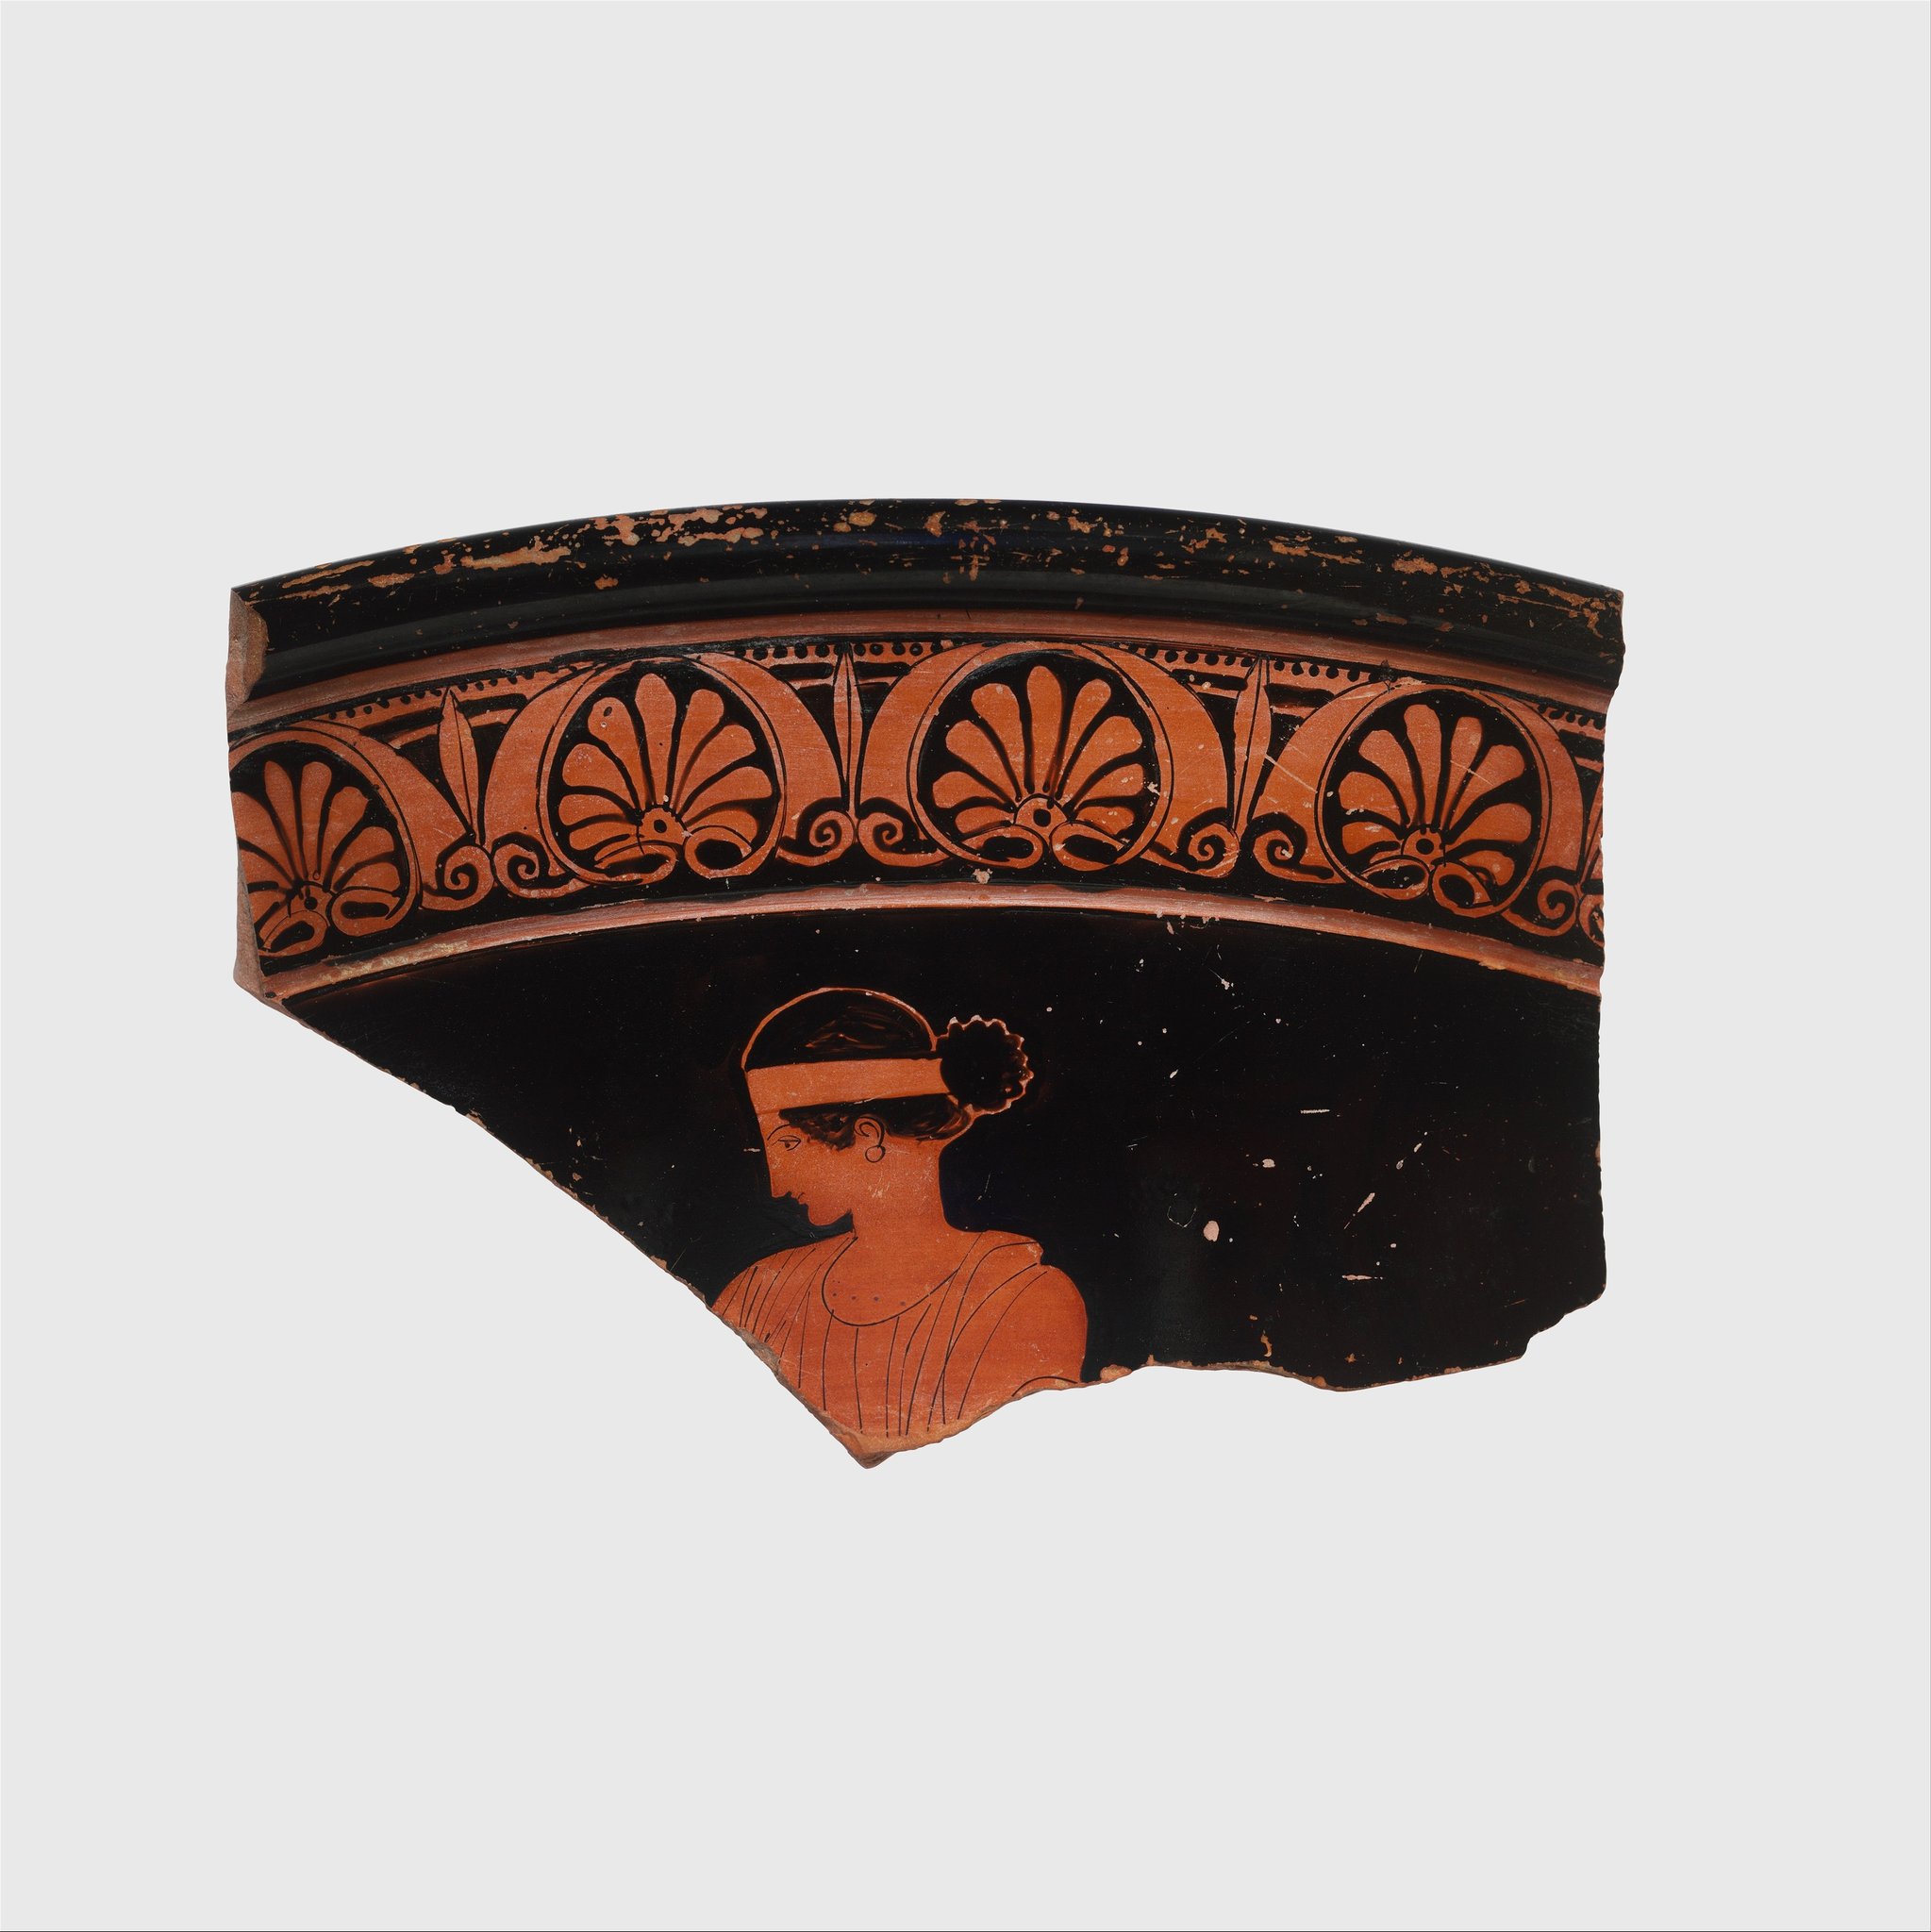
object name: calyx krater fragment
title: Fragment of a terracotta calyx-krater (bowl for mixing wine and water)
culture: greek, attic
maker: chicago painter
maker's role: artist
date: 450 BCE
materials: terracotta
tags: palmettes,profiles,women